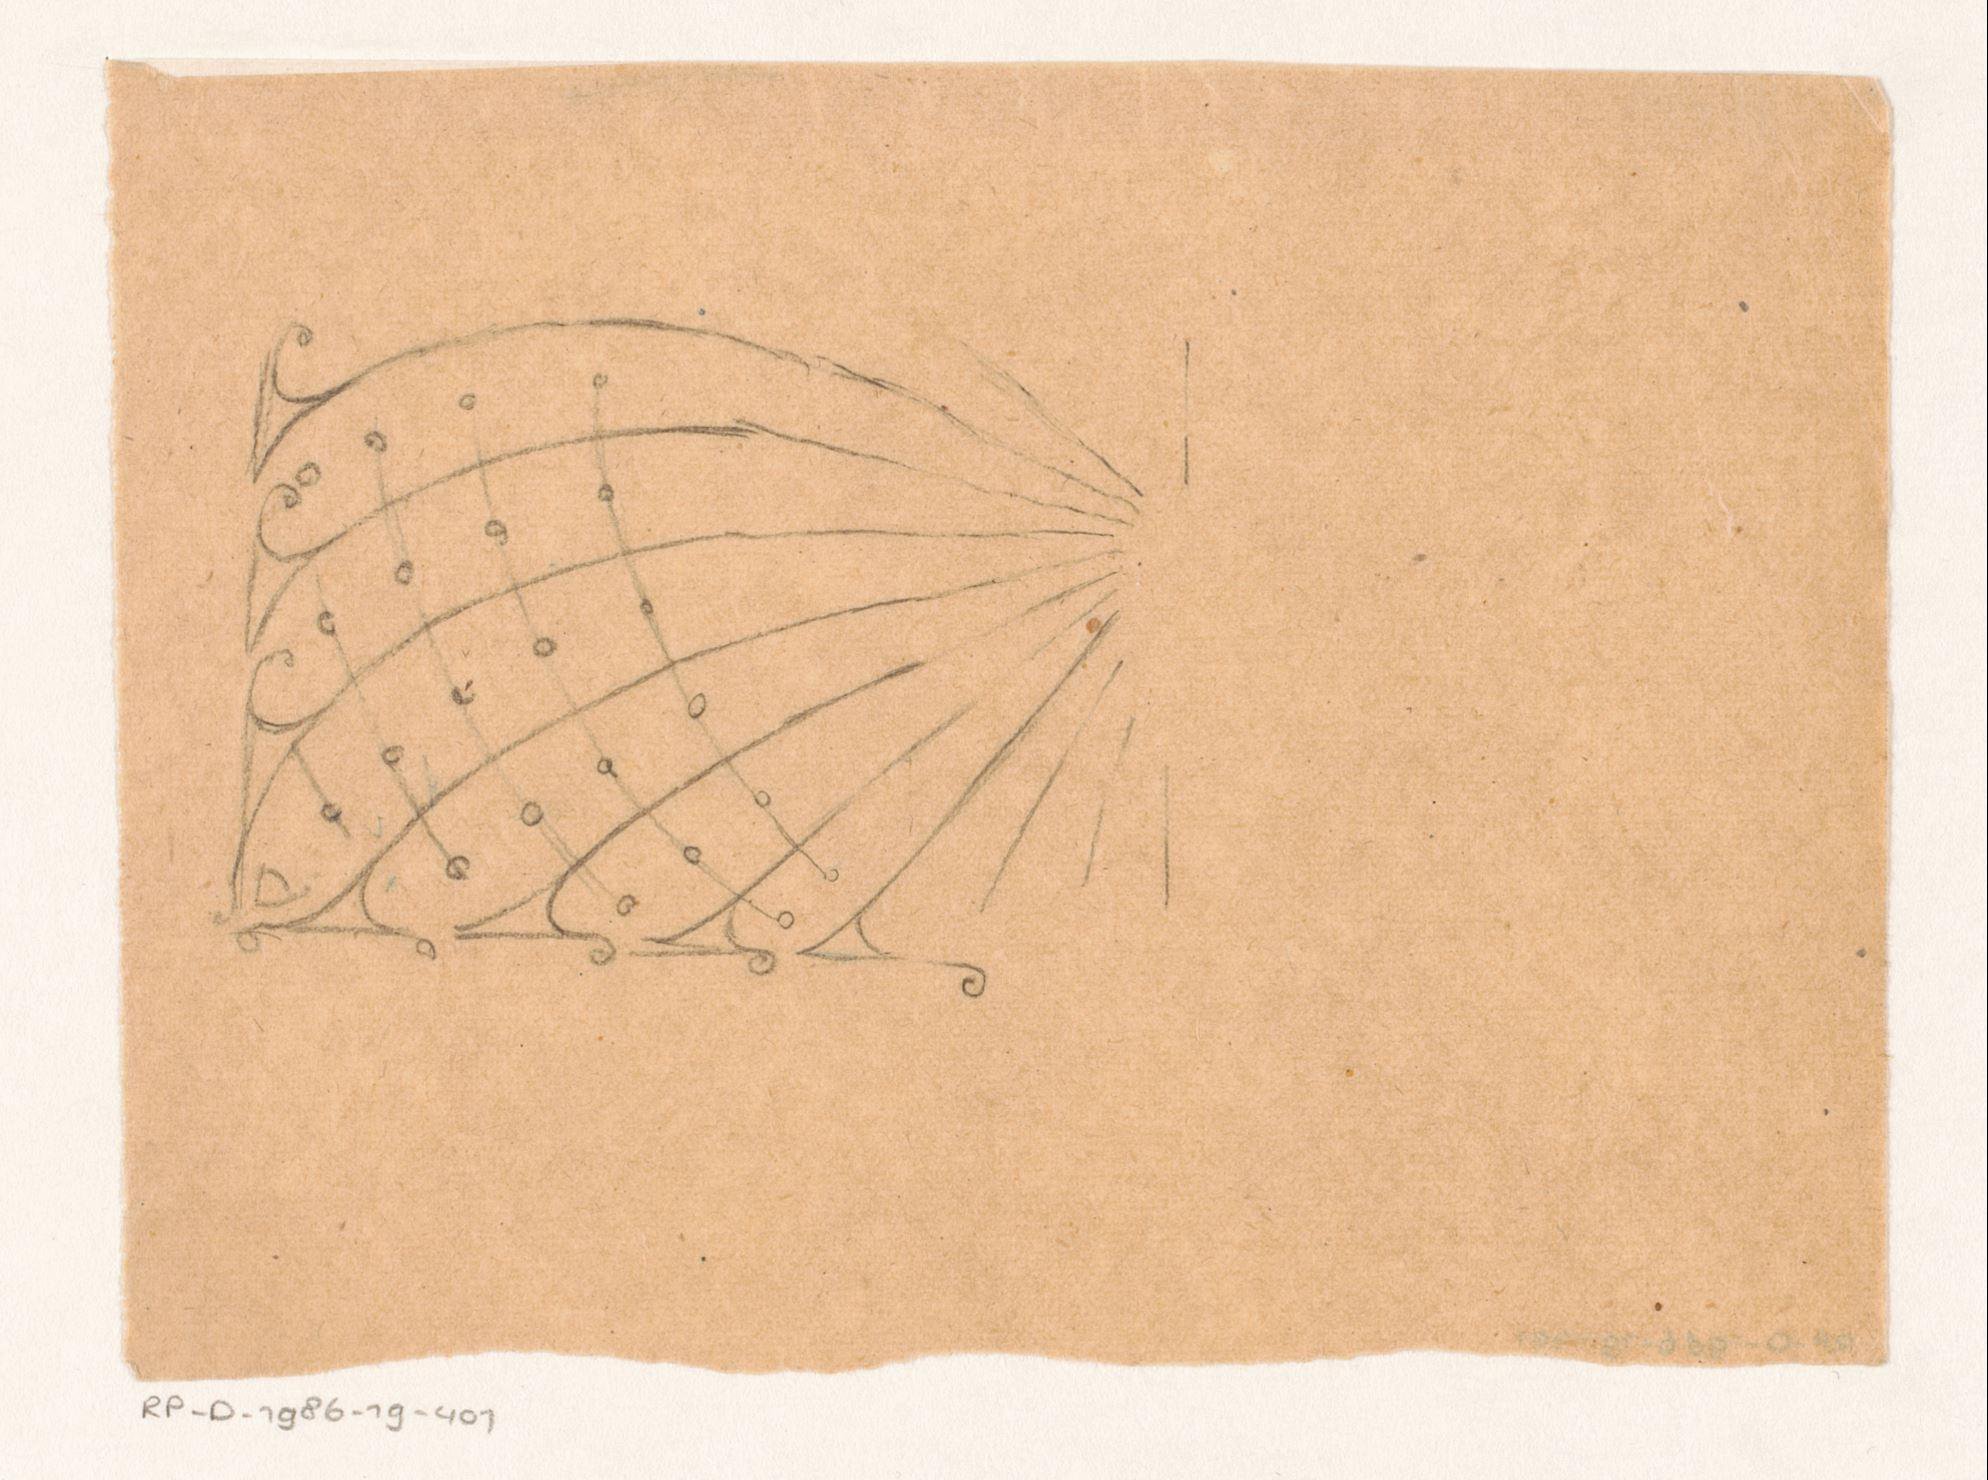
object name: drawing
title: Ornament met kruisende lijnen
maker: reinier willem petrus de vries (1874-1953)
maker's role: draughtsman, print maker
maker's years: 1874-1953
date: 1884-1952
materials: paper, pencil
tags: ornament ~ geometric motifs